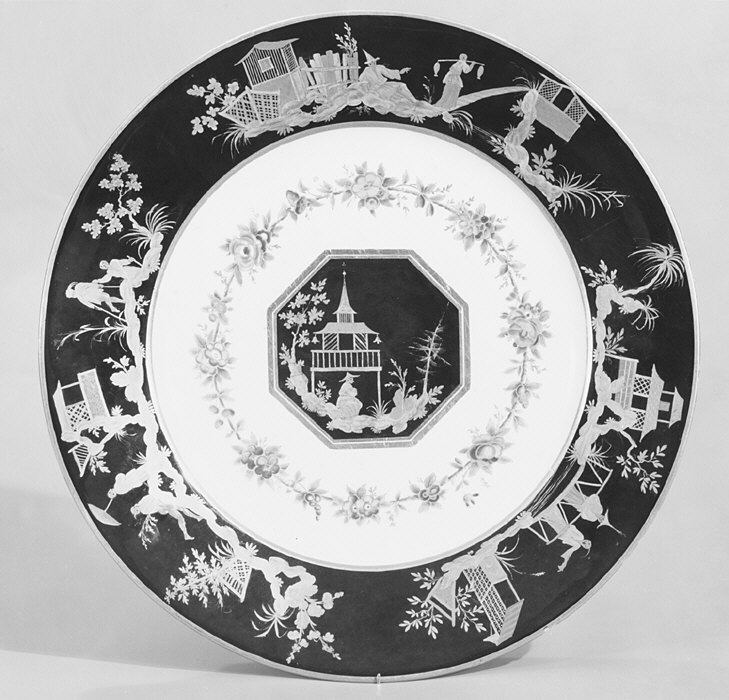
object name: plate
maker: sèvres manufactory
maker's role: manufactory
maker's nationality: french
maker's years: 1740-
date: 1791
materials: hard paste porcelain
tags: human figures,chinoiserie,flowers